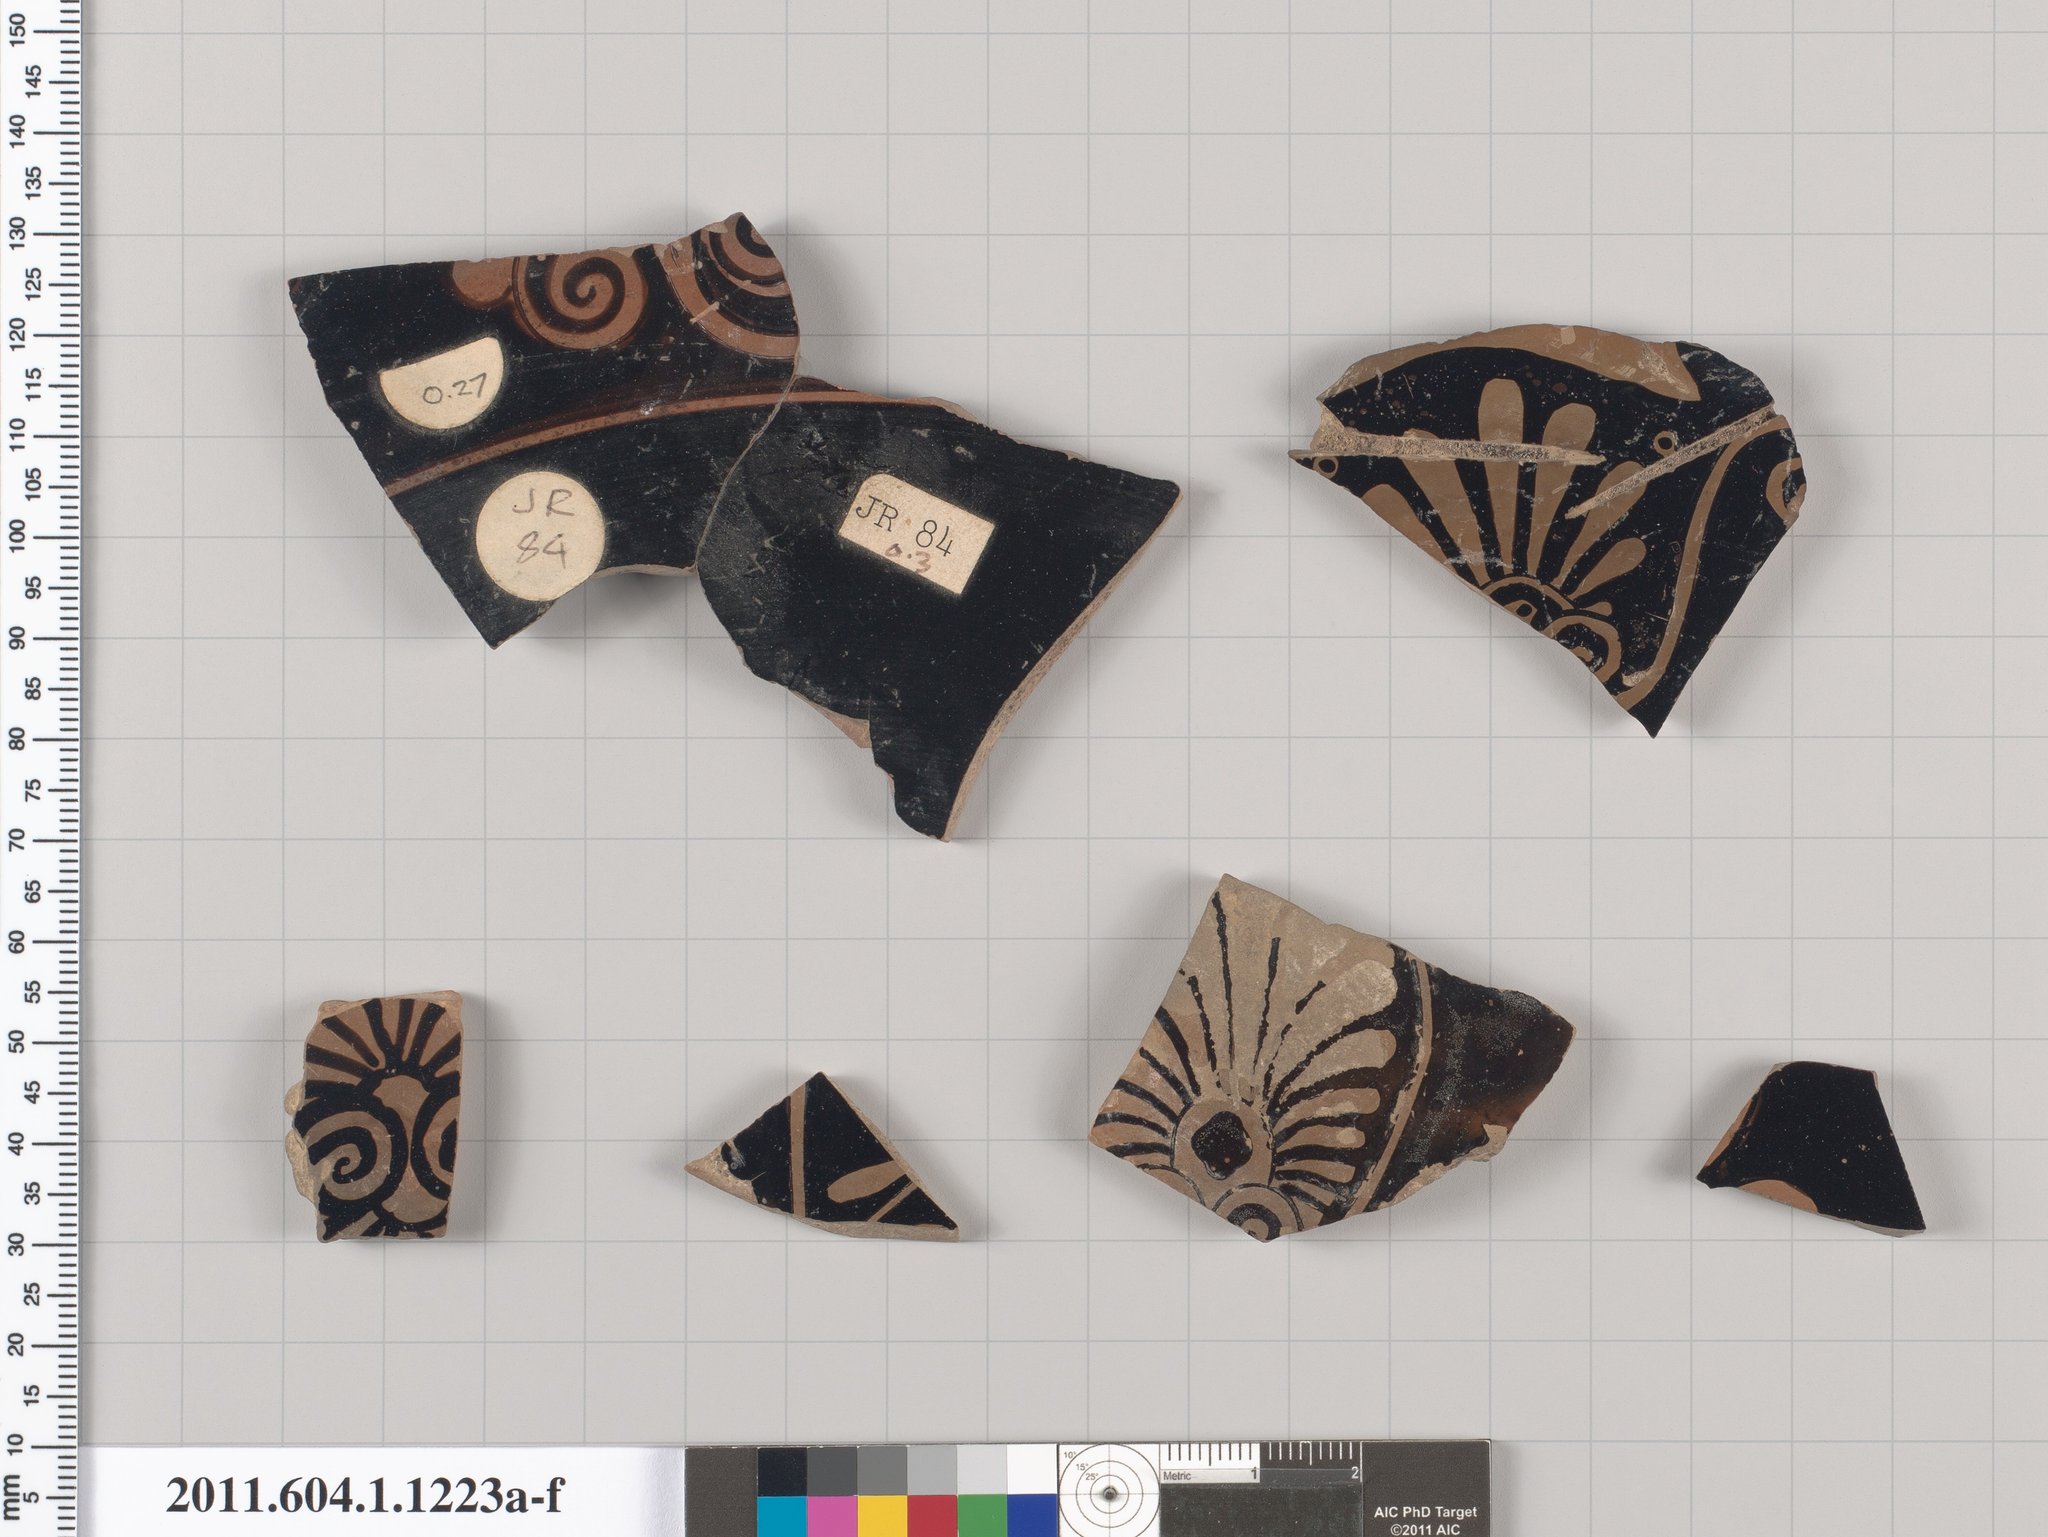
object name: kylix fragment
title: Terracotta fragments of kylikes (drinking cups)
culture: greek, attic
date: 600-401 BCE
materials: terracotta